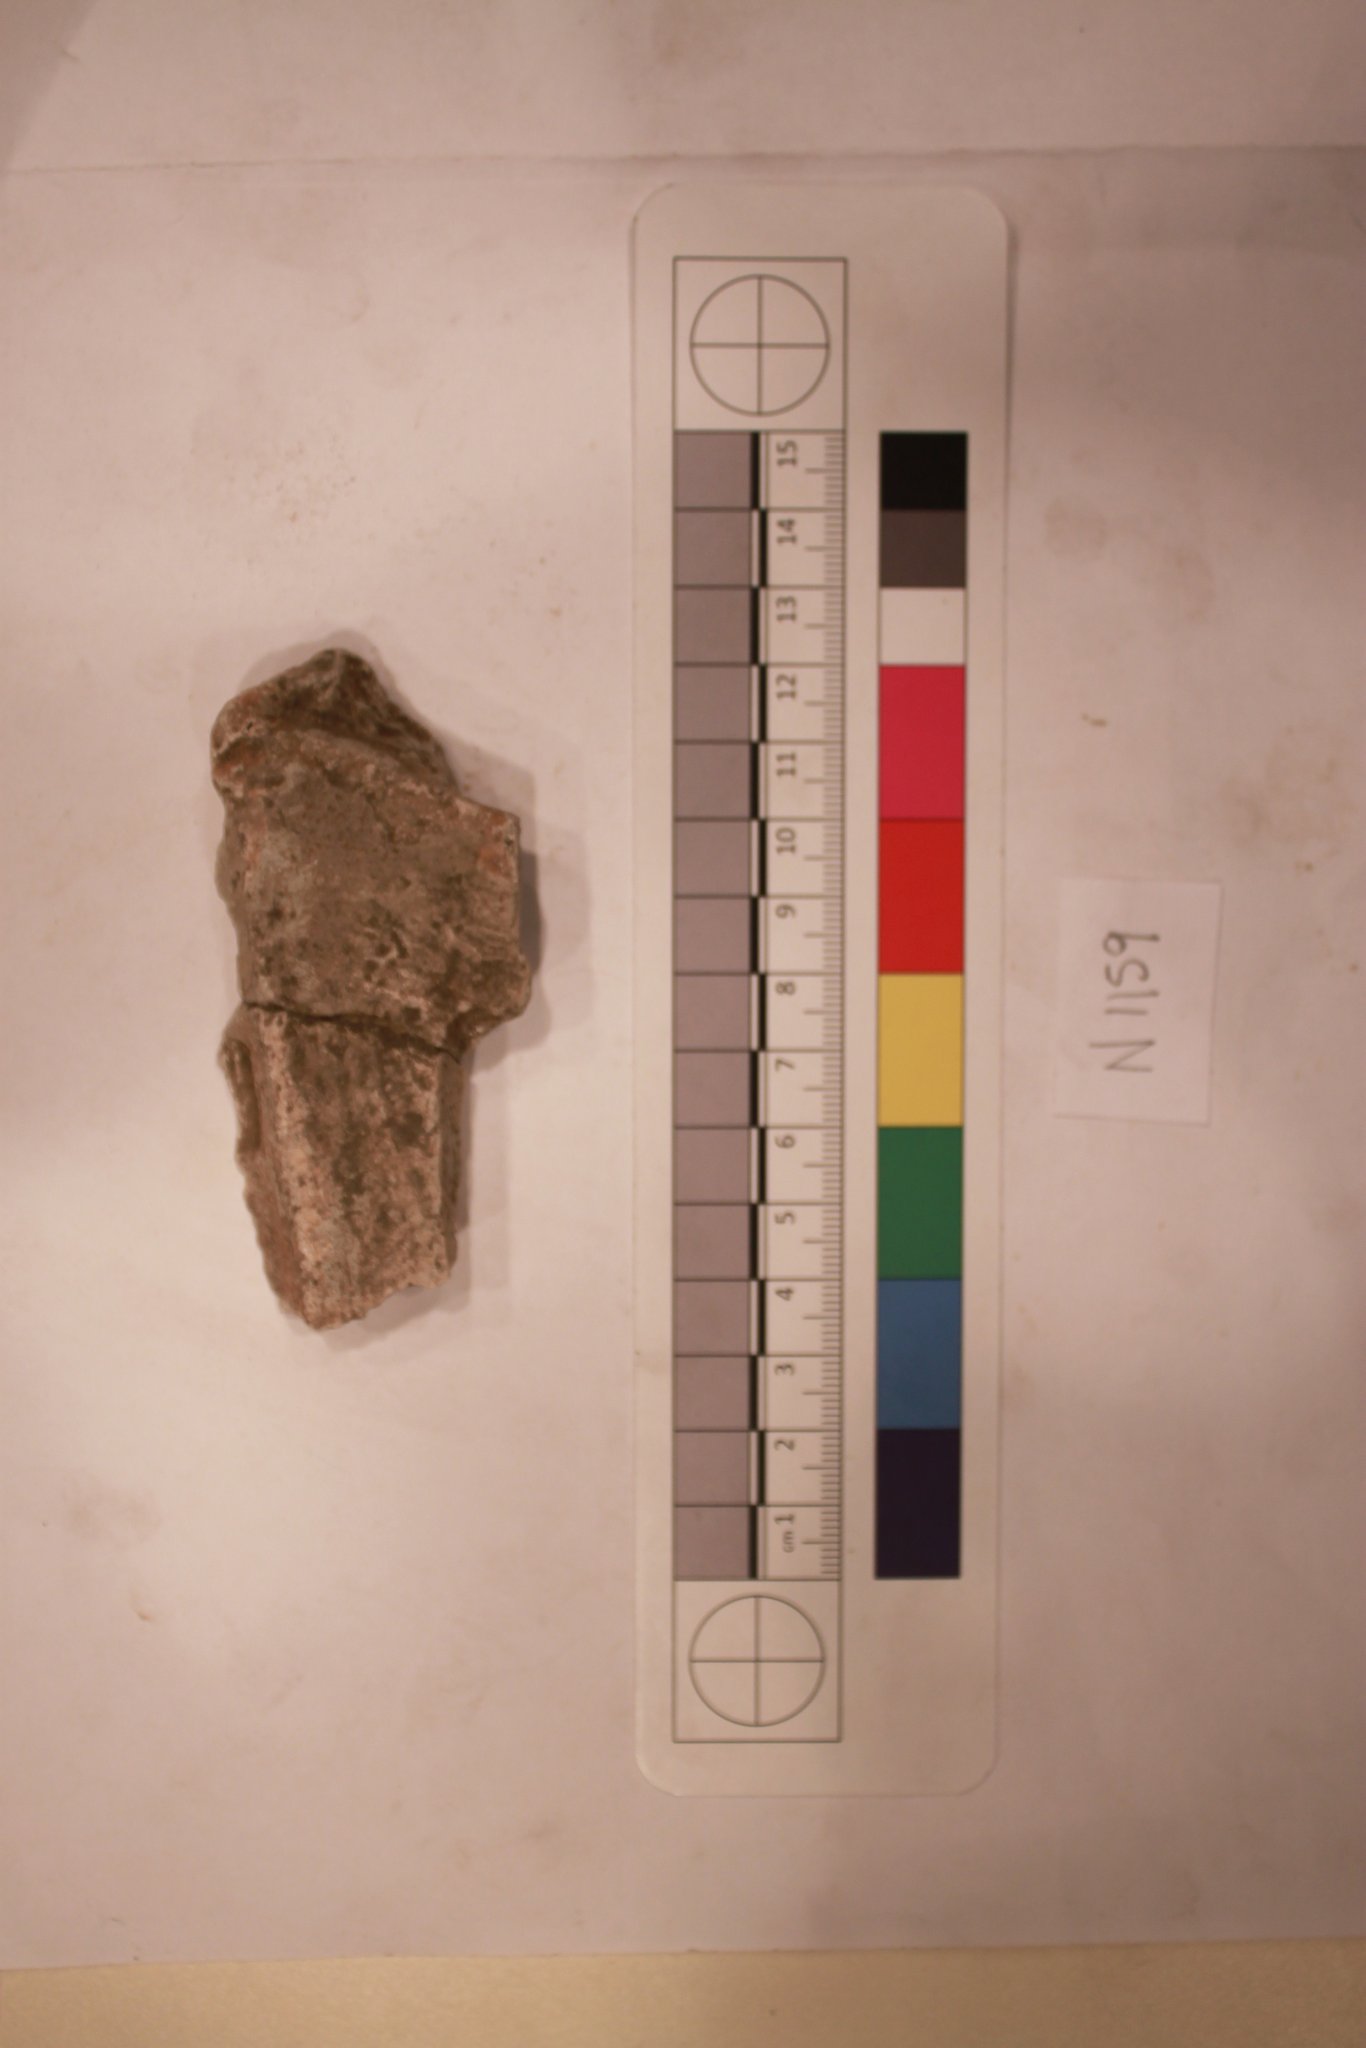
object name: fragment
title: Stucco Fragment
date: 701-1200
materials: plaster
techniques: carving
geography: iran